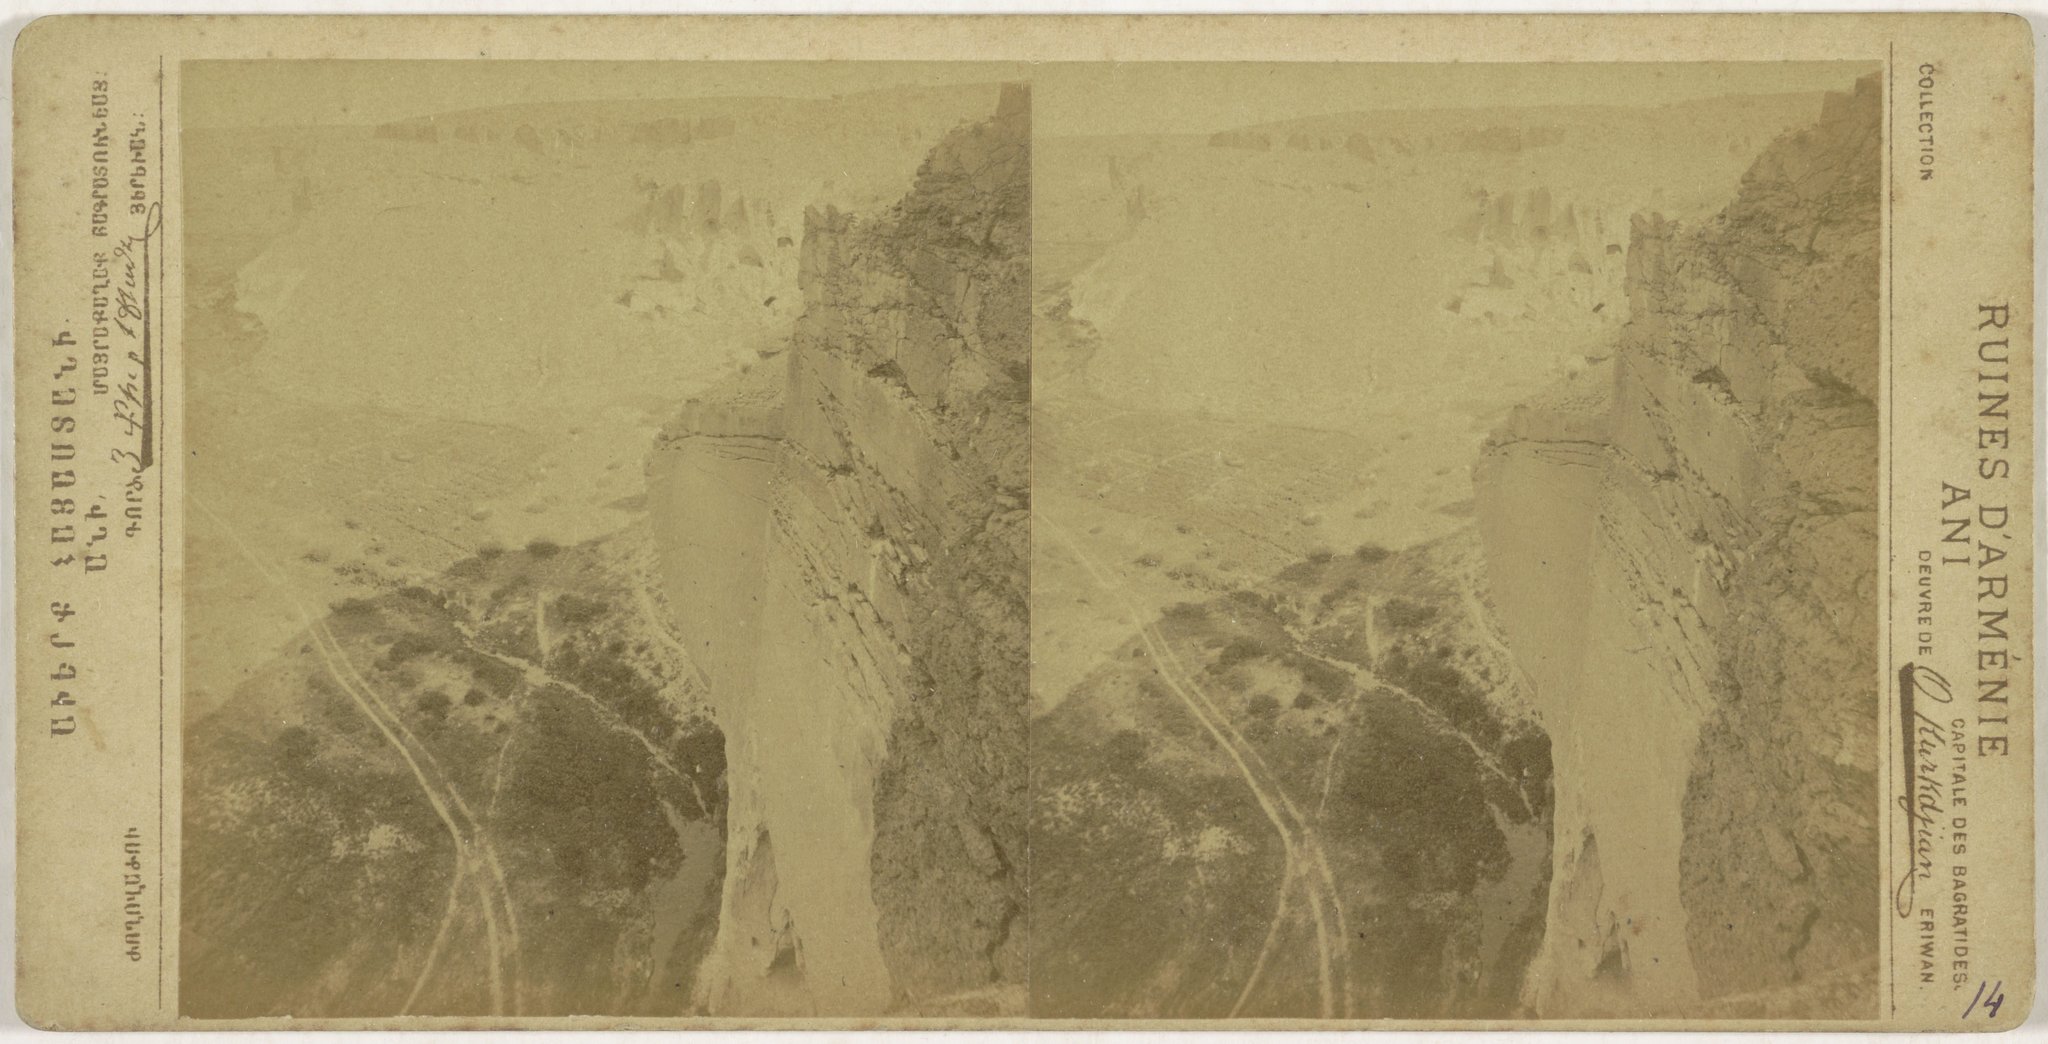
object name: stereograph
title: Ruines d'Arménie. Ani Capitale des Bagratides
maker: onnes kurkdjian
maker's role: fotograaf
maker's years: 1851-1903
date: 1875-1880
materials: cardboard, paper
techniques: albumen print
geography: vienna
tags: dale, valley, ruin of a building ~ architecture, inland cliff face, city-walls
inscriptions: inscription: ‘Collection Oeuvre de O. Kurkdjian Eriwan’, inscription: ‘Tous droits résérvés.’, number: ‘14’